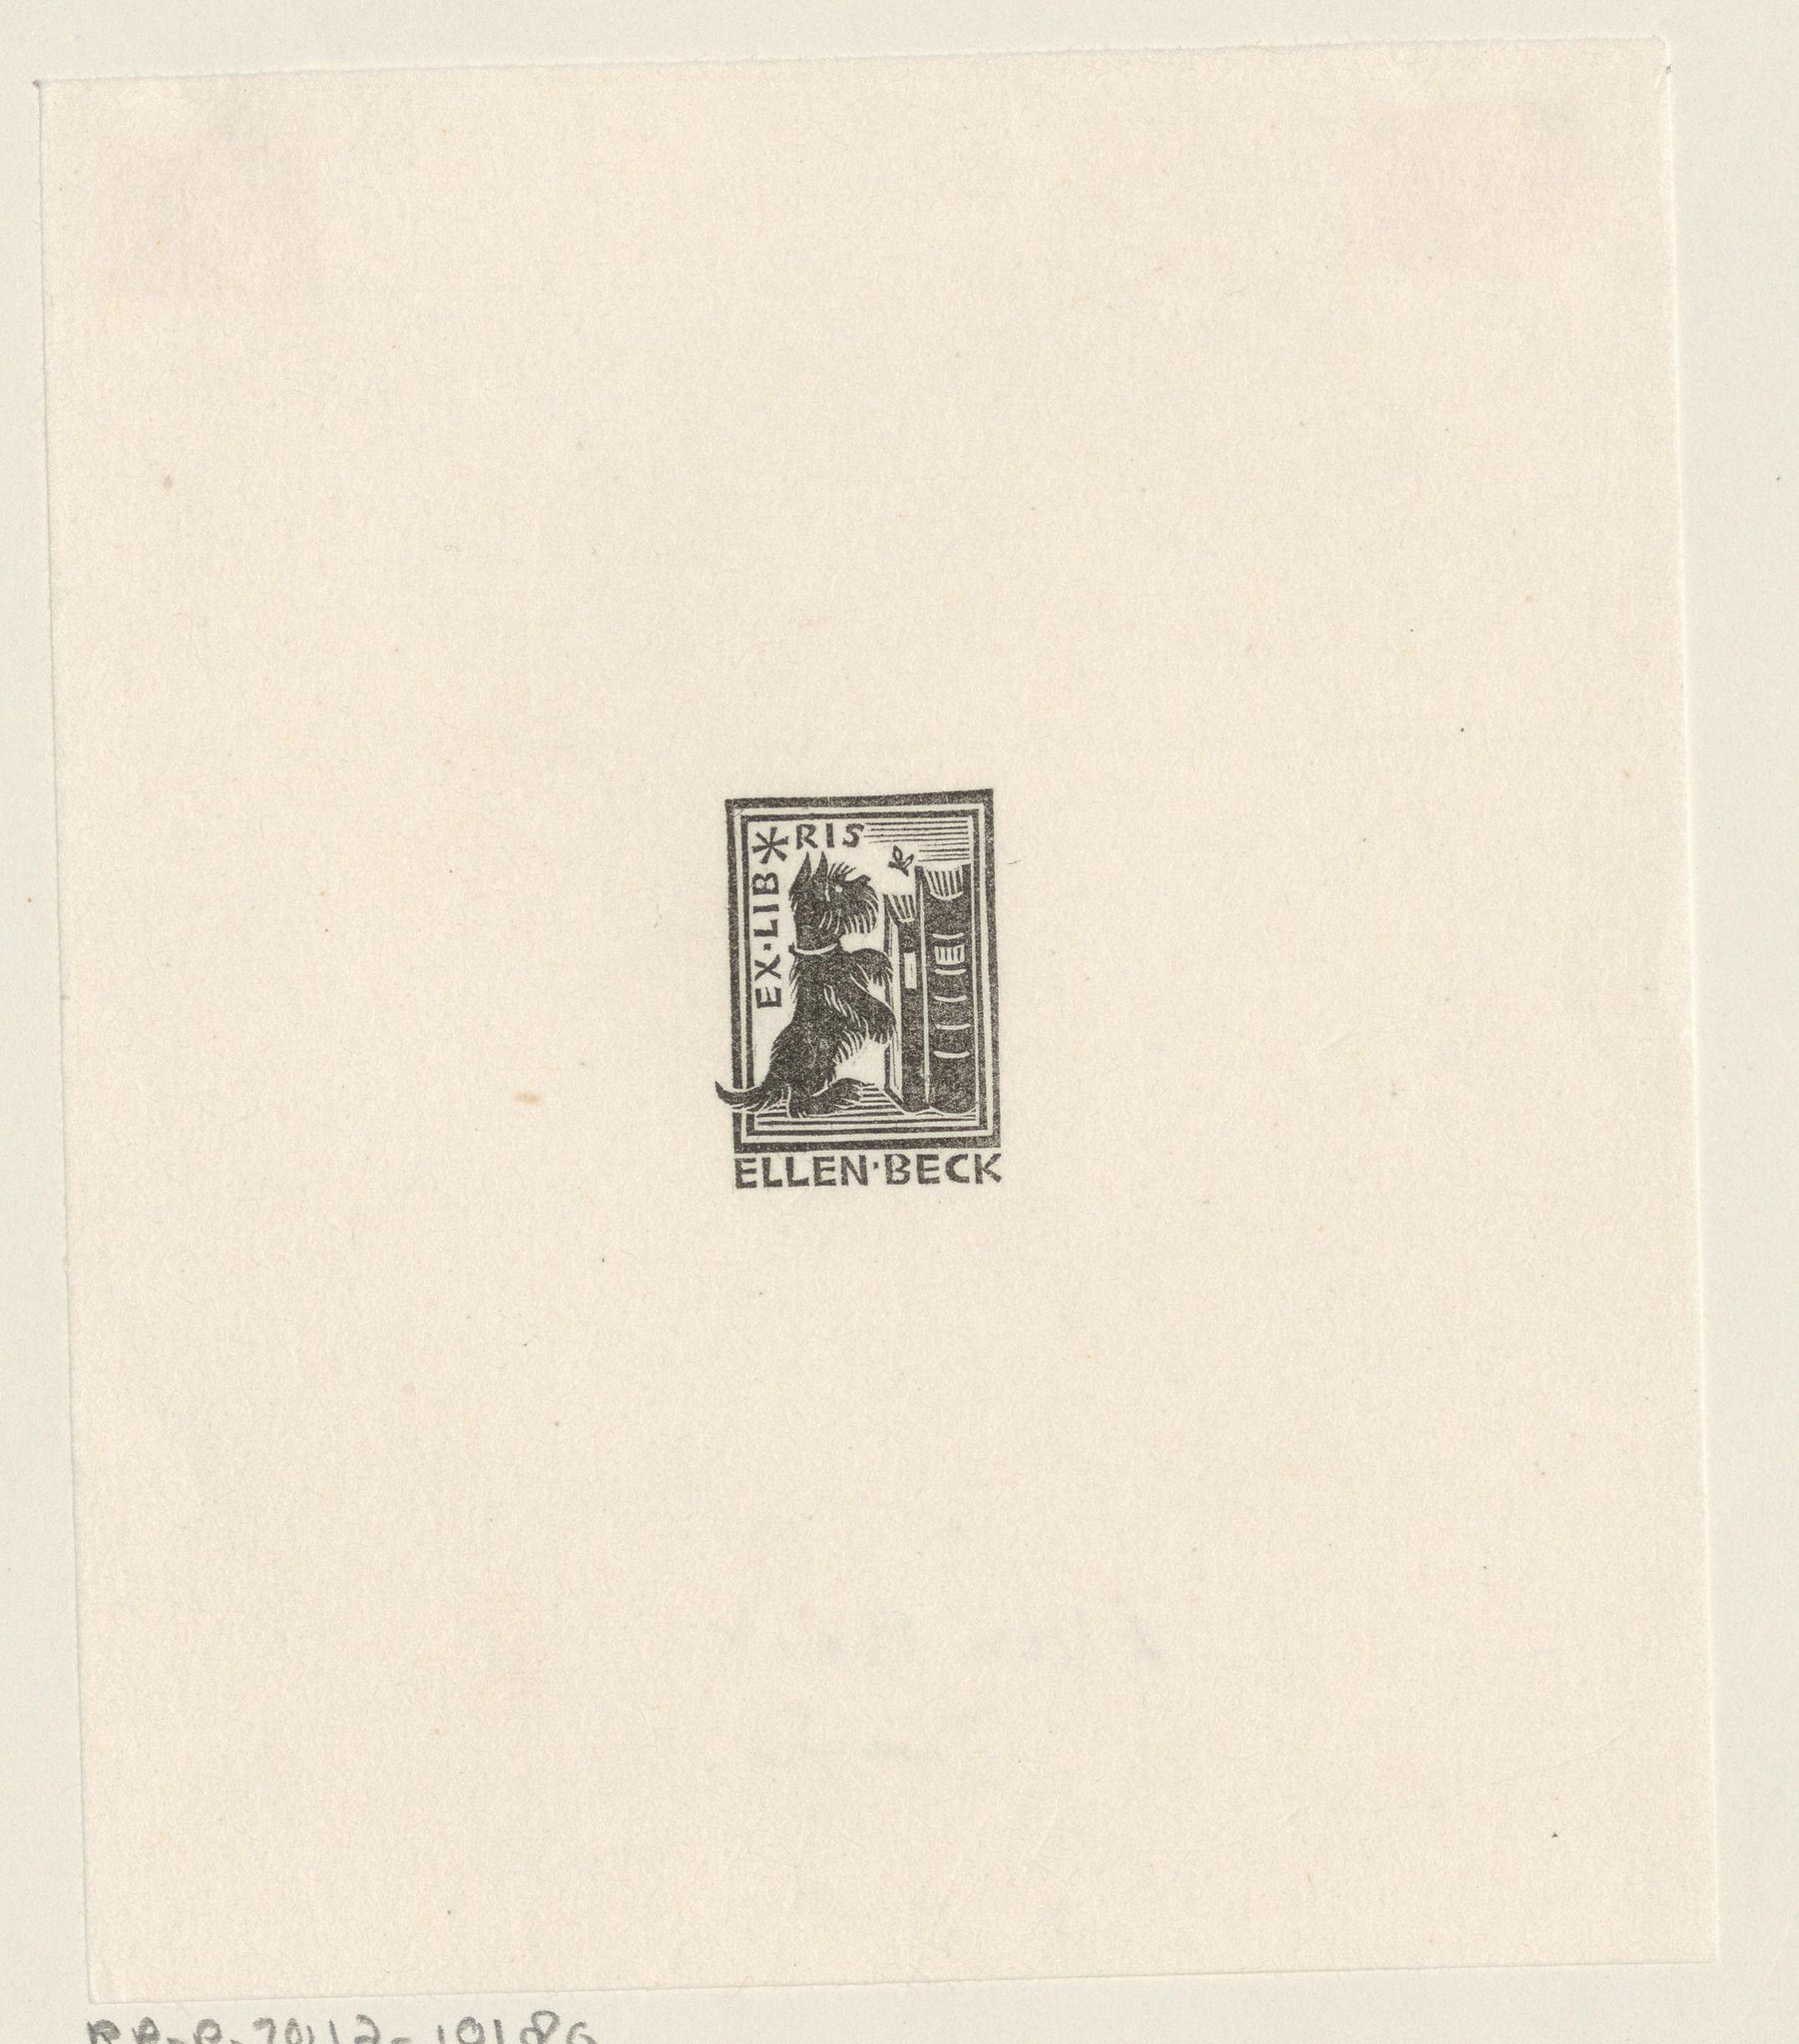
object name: bookplate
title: Ex libris van Ellen Beck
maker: ellen beck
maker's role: print maker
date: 1900-1999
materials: paper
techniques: woodcut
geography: germany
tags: print maker, ellen beck, book, dog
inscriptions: inscription: ‘Ellen Beck/ Duits’